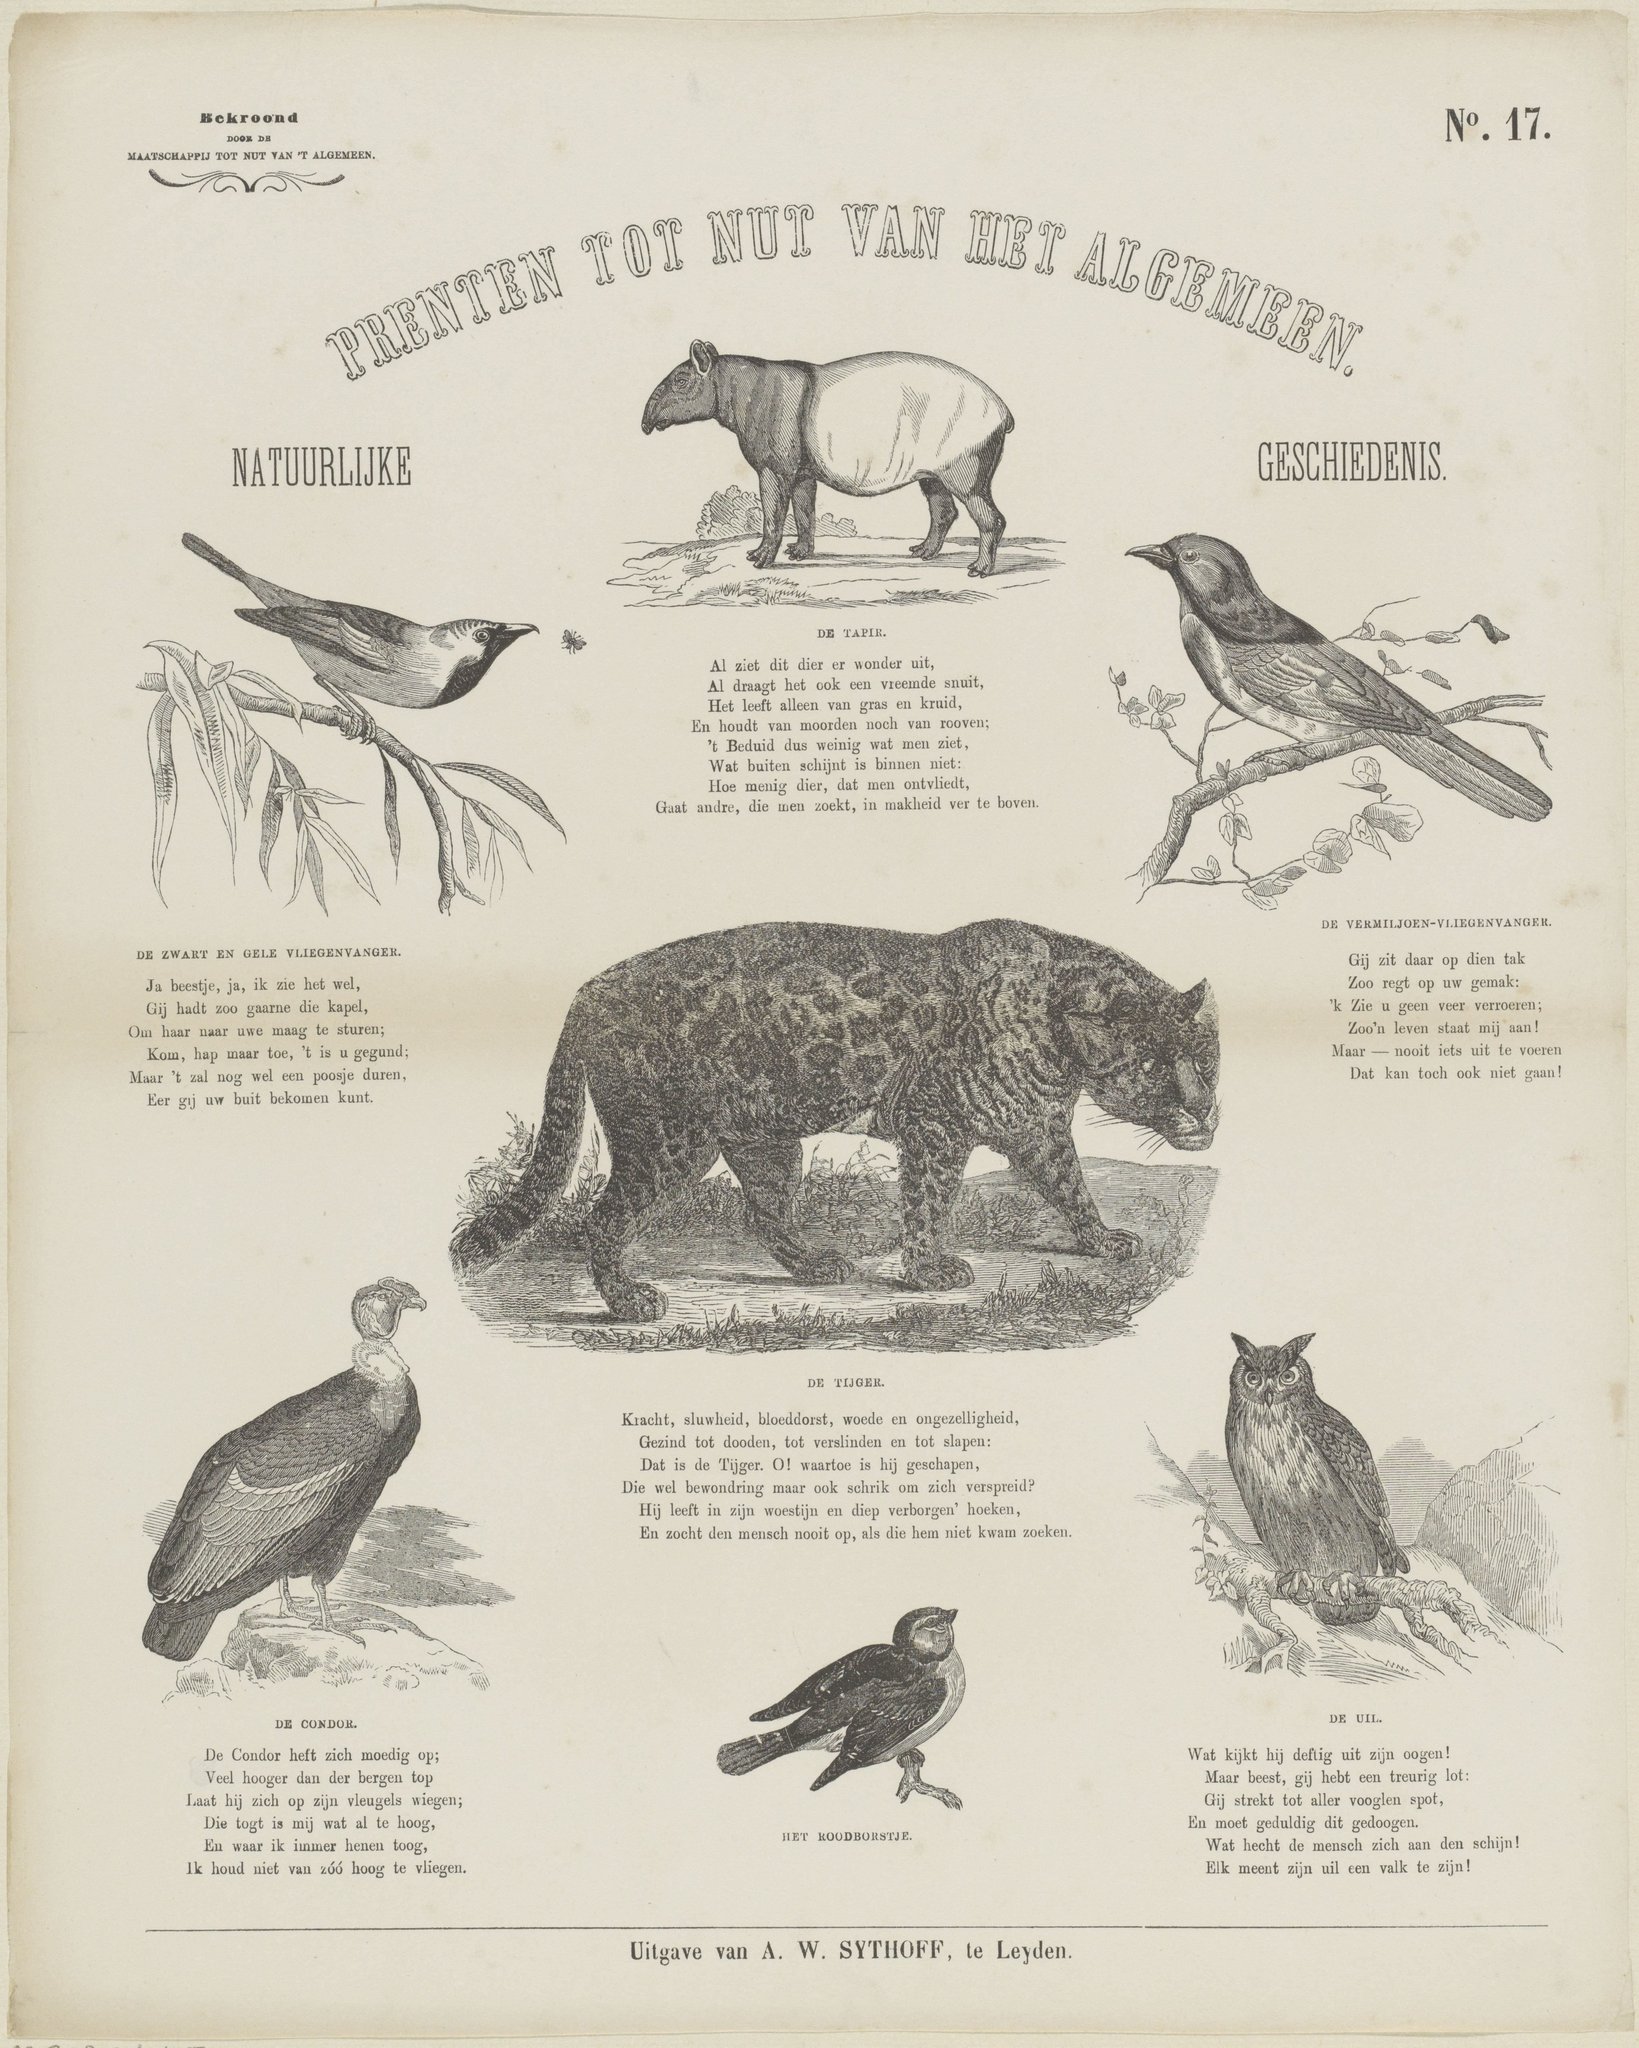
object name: popular print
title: Natuurlijke geschiedenis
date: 1861-1929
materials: paper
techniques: letterpress printing, engraving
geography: leiden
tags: beasts of prey, predatory animals: tiger, animals, birds, owls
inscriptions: collector's mark: Lugt 2760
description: Blad met 7 voorstellingen van dieren, zoals een tapir, een tijger en een uil. Onder elke afbeelding een titel en een onderschrift. Genummerd rechtsboven: No. 17. Linksboven: Bekroond door de Maatschappij tot Nut van 't Algemeen.